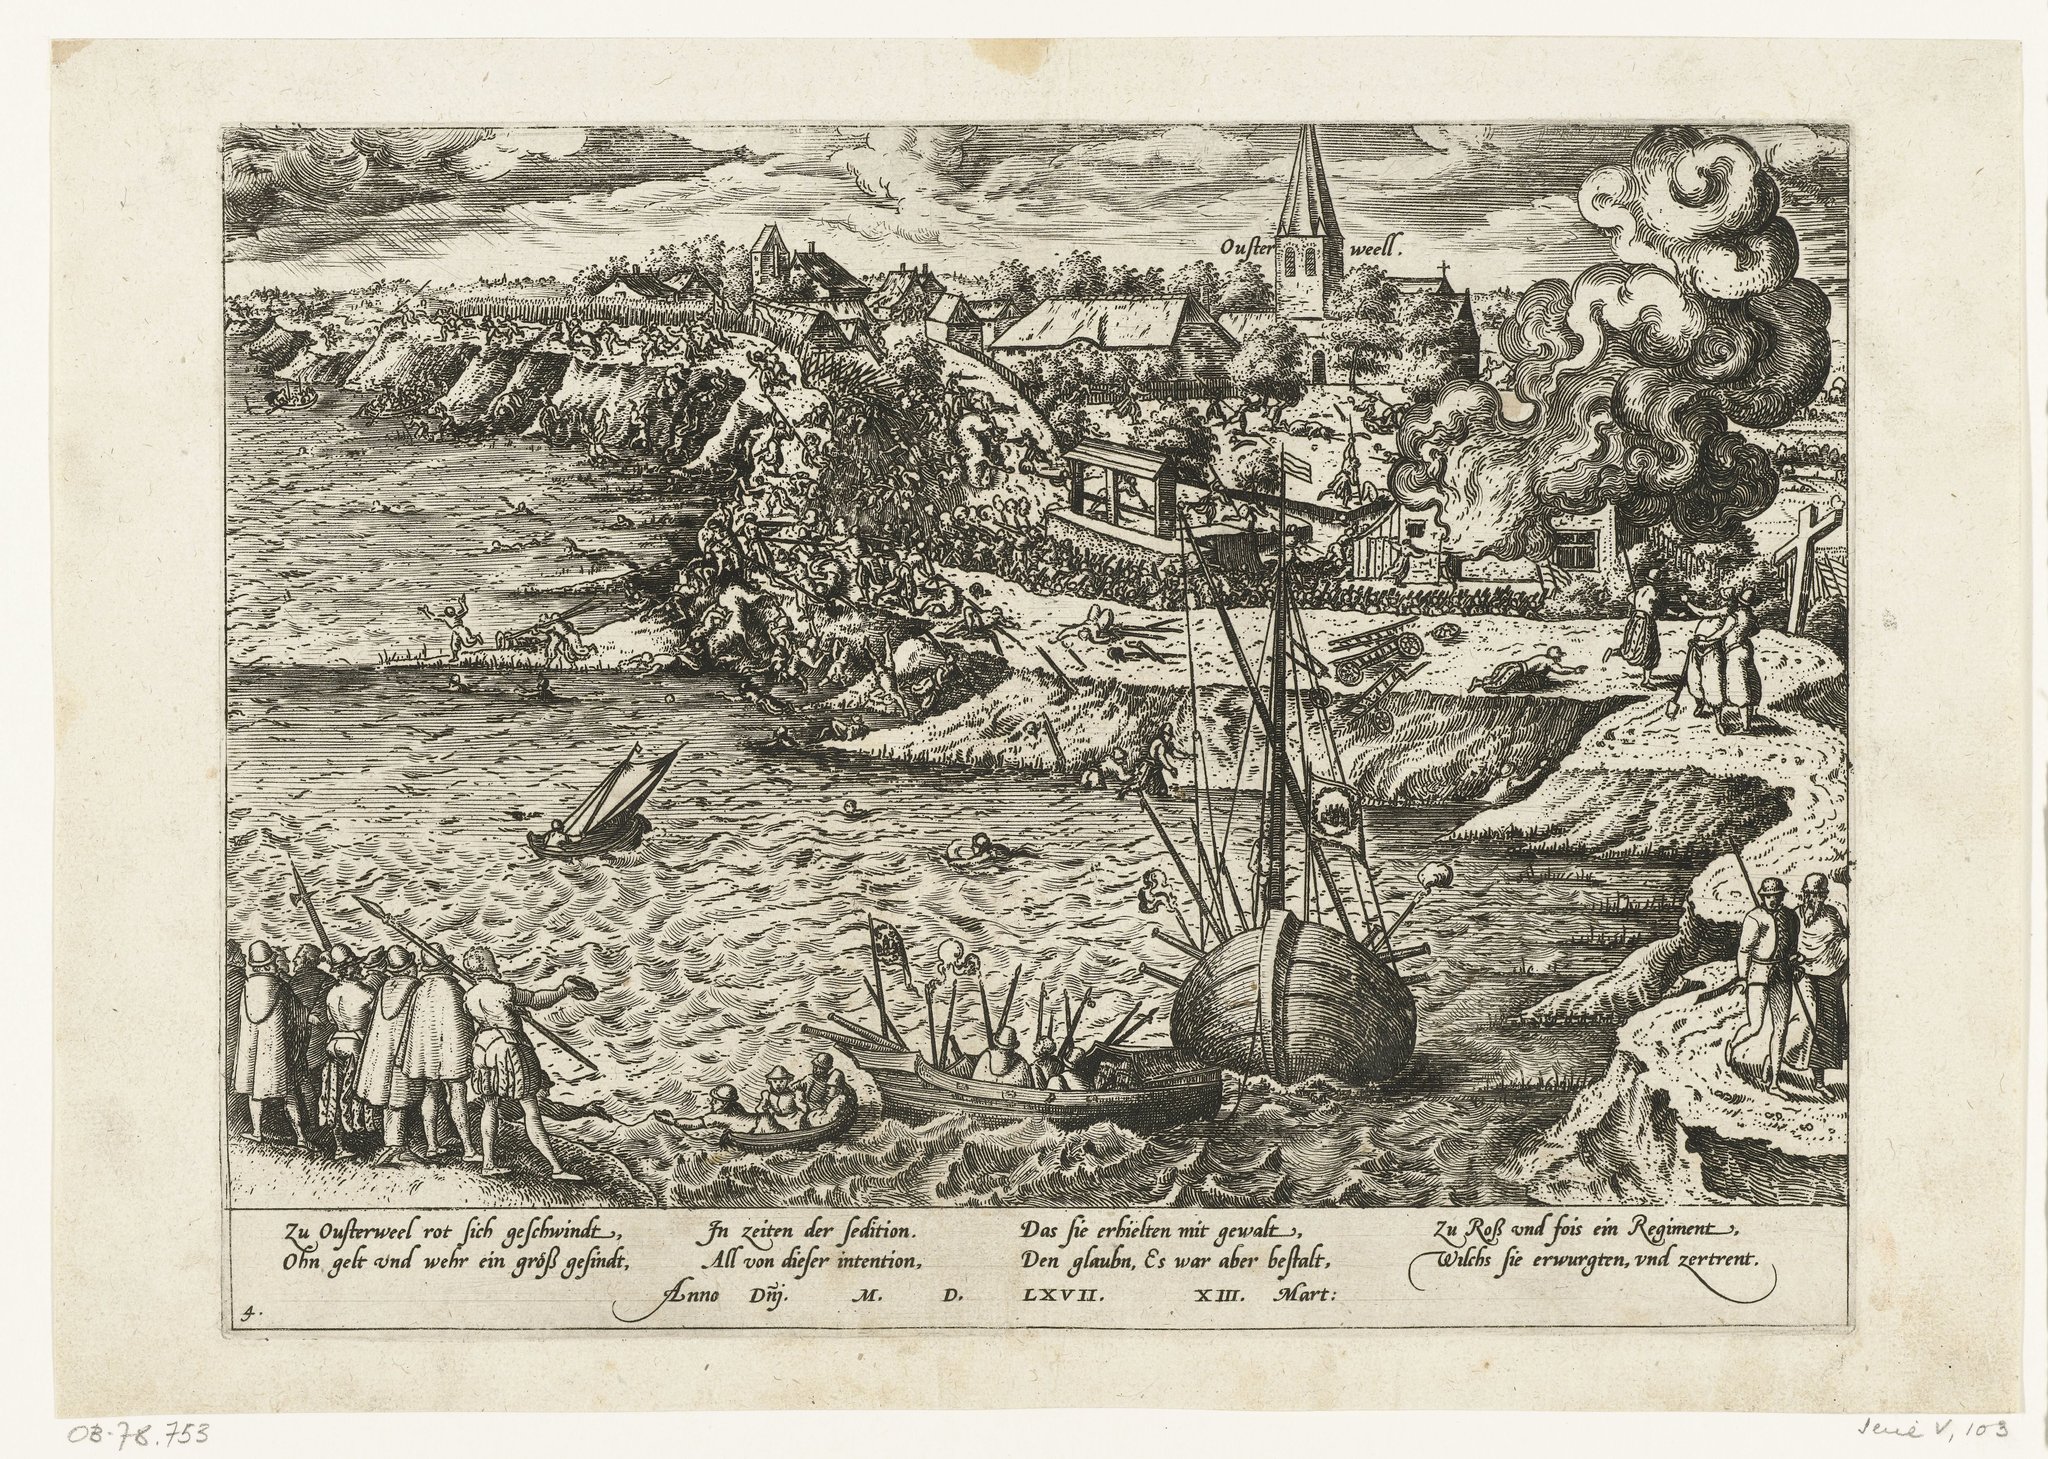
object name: print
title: Serie 5: Nederlandse Gebeurtenissen, 1566-1570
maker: frans hogenberg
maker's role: print maker, publisher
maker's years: 1538-1590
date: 1566-1570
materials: paper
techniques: etching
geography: cologne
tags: battle, fighting in general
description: De slag bij Oosterweel, in de nacht van 13 op 14 maart 1567. Gevechten rond de dijk bij de waterkant, rechts een brandend gebouw. De calvinisten onder leiding van Jan van Marnix worden verslagen door de troepen van de hertog van Aremberg en Philips van Lanoy. Met onderschrift van 8 regels in het Duits. Genummerd: 4.